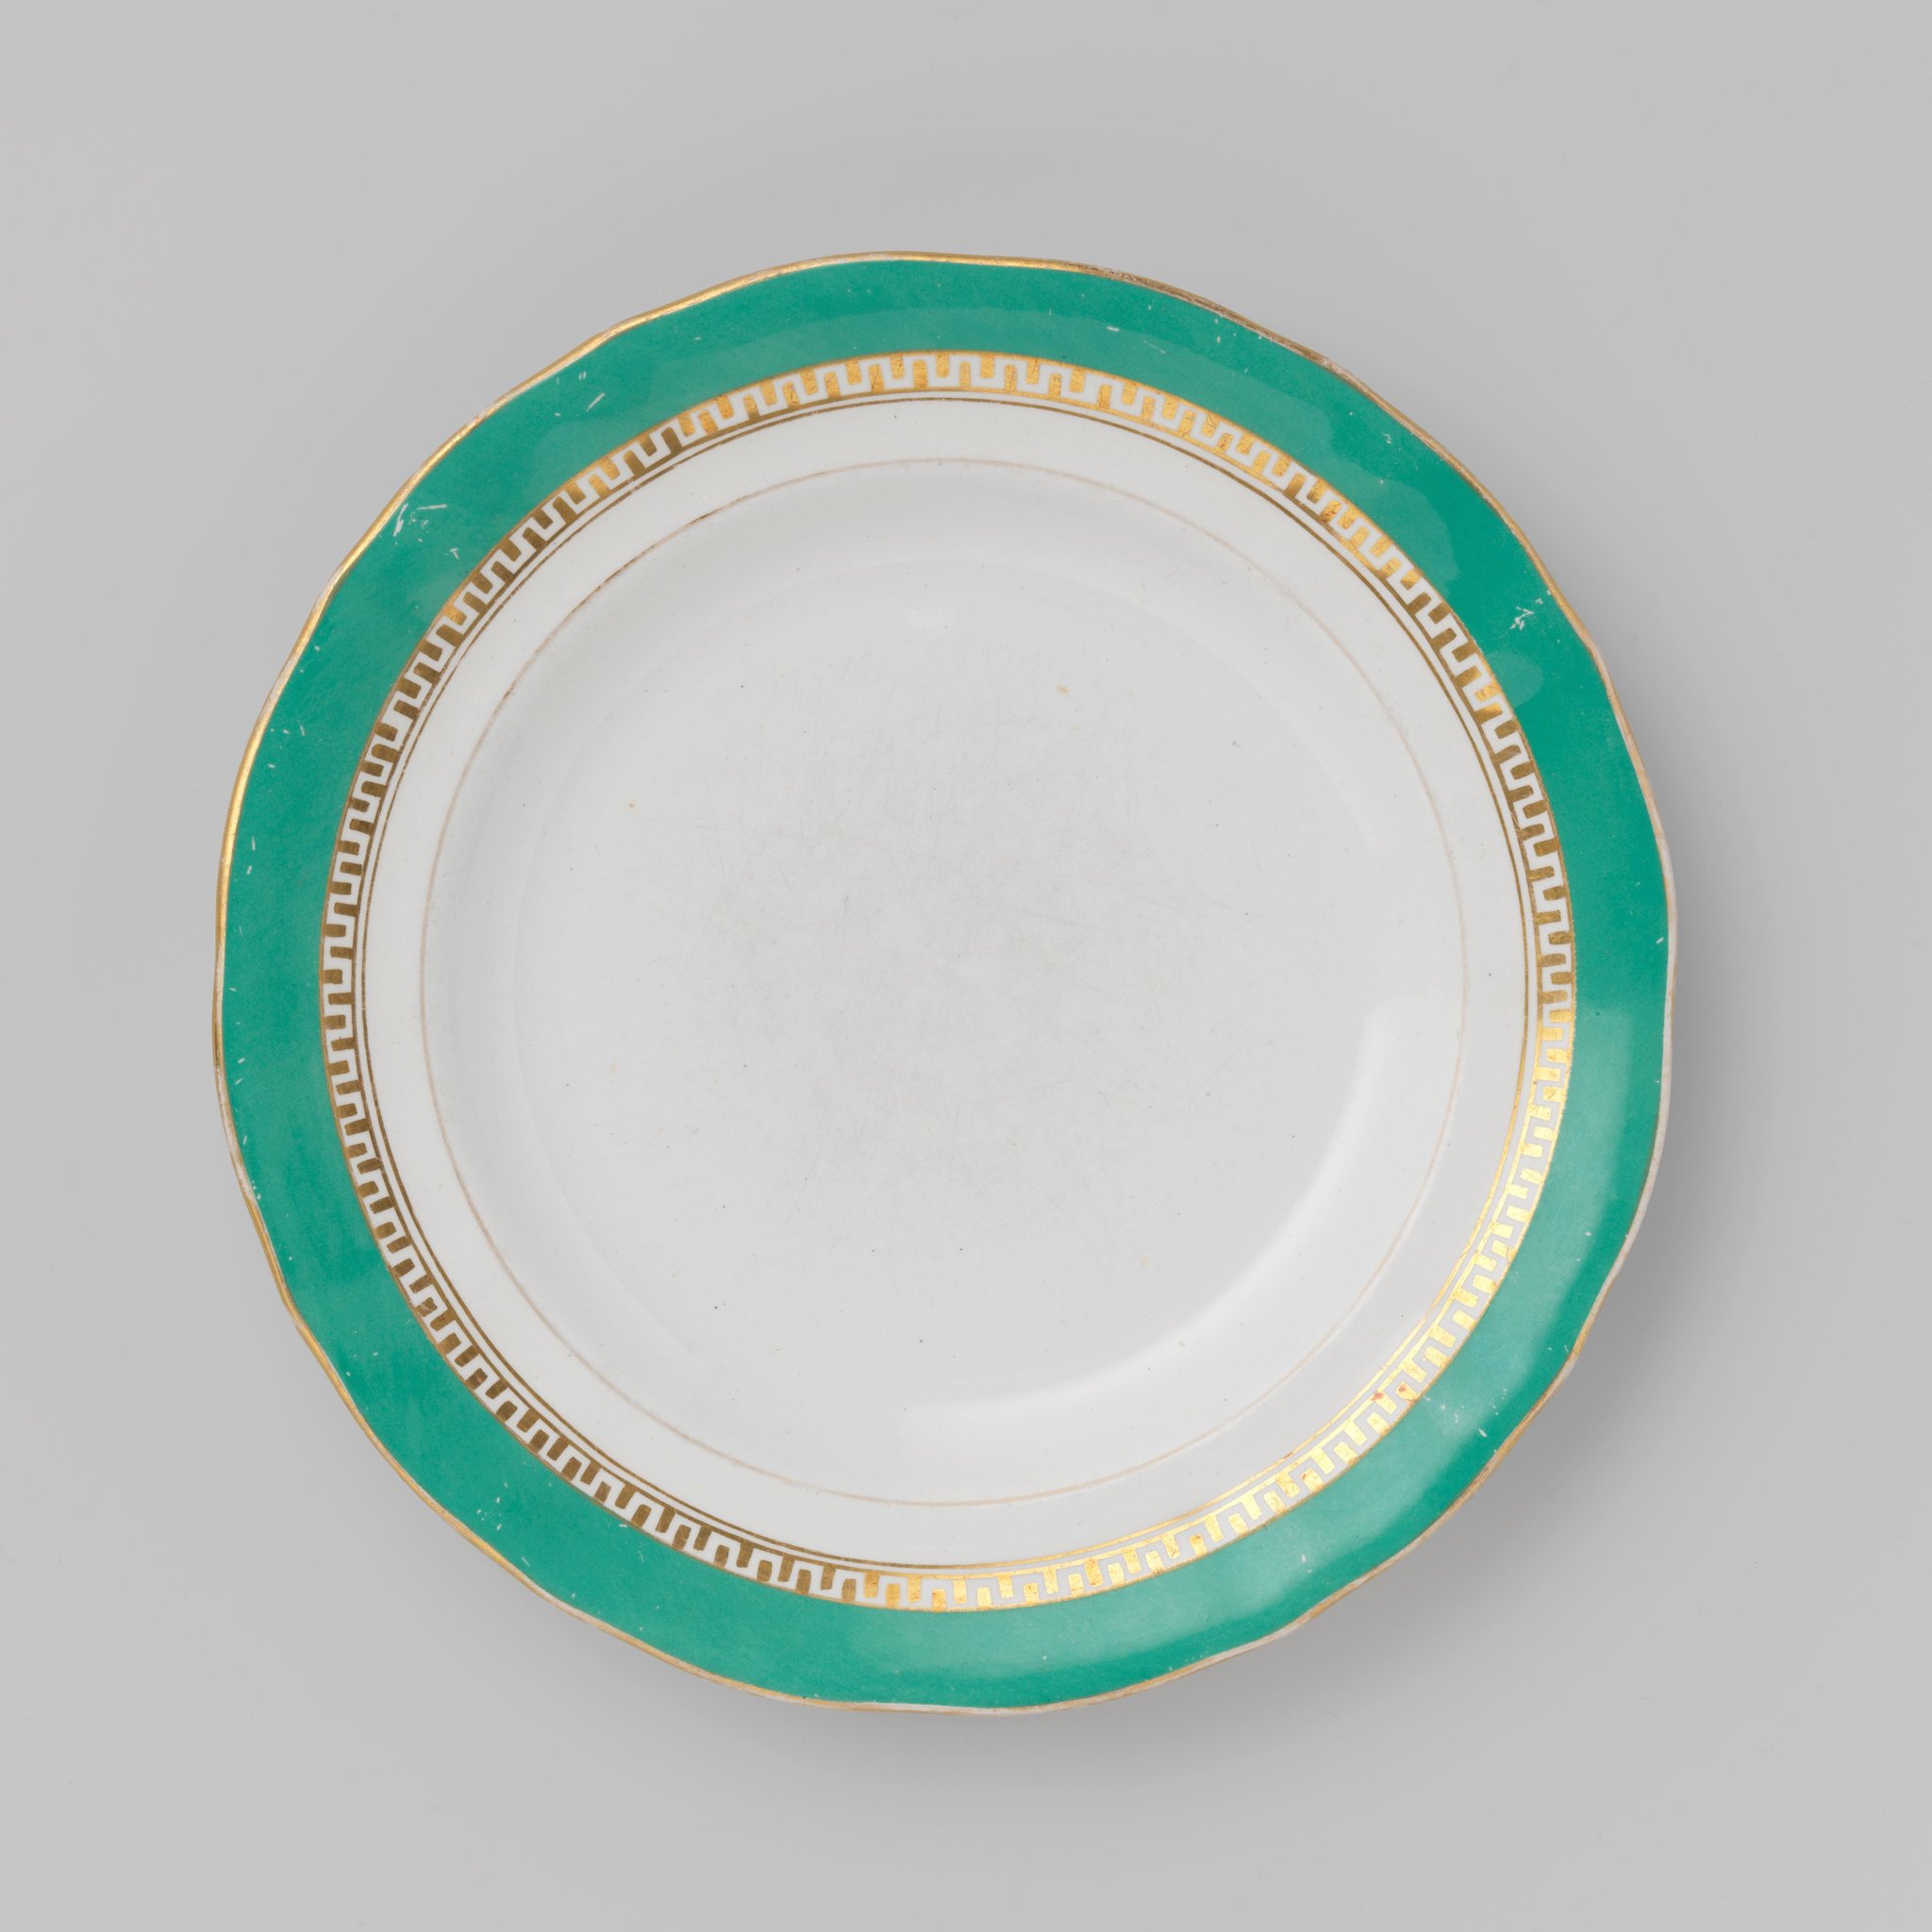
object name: plate dish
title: Bord met groene rand en gouden Griekse band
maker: petrus regout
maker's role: plateelbakker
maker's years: 1801-1879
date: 1865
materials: earthenware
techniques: transfer decoration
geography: maastricht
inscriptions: check stamp: ‘P. REGOUT // MAASTRICHT // 17X’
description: Bord van aardewerk, geschulpt, met groene rand en gouden Griekse band.